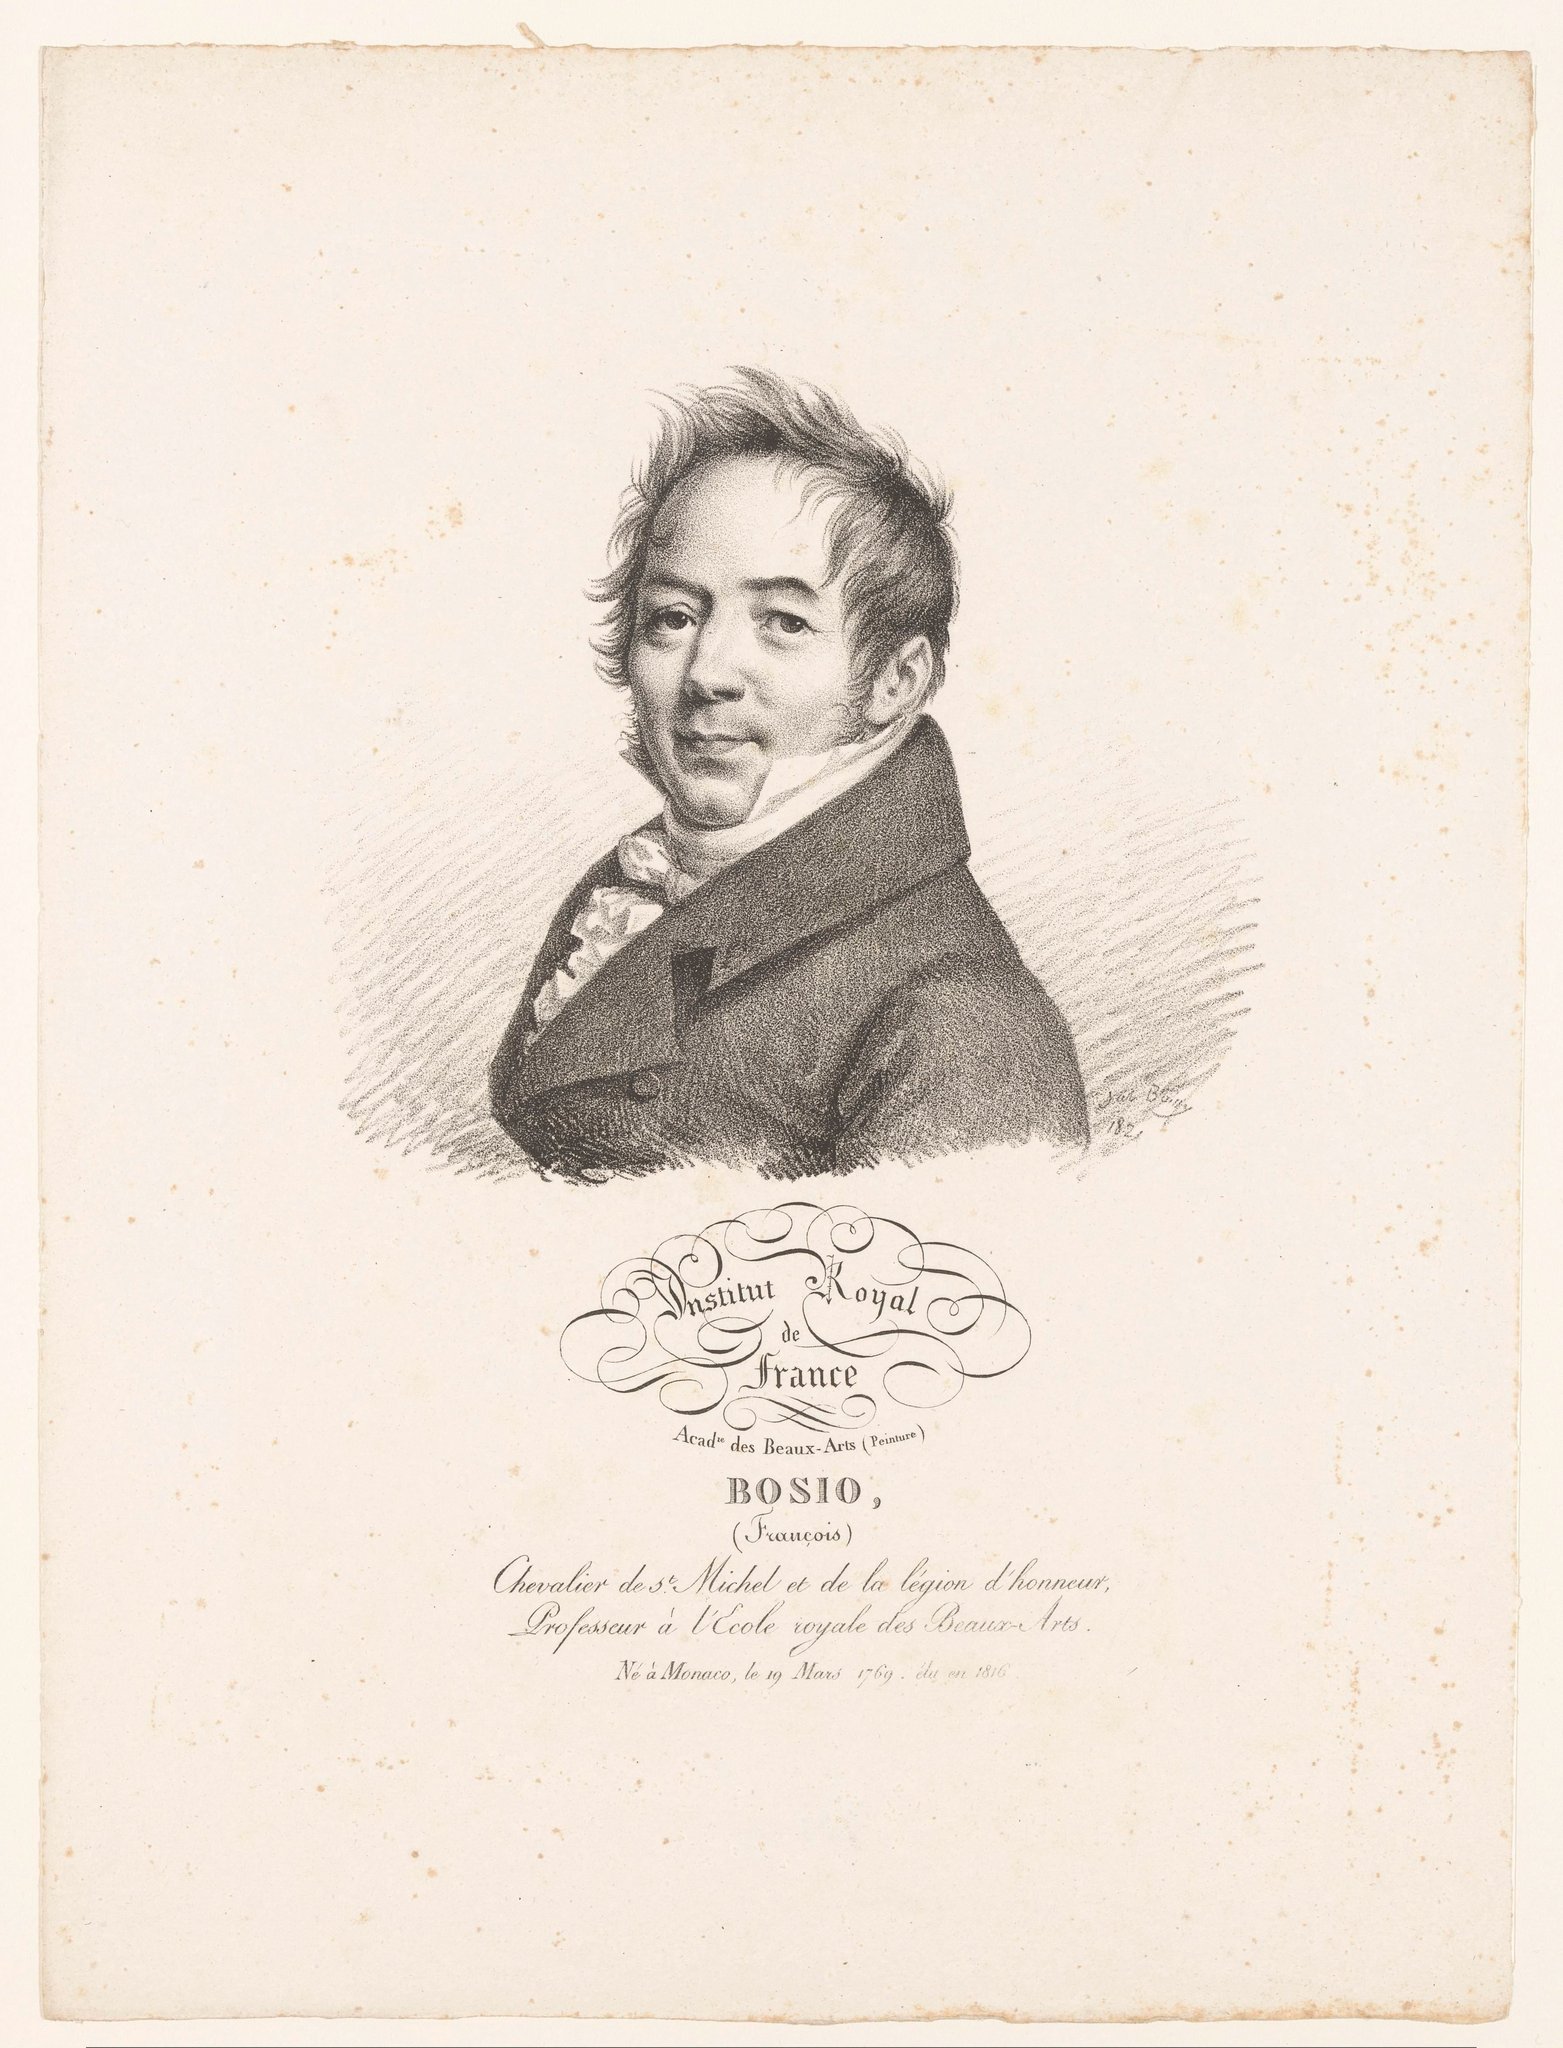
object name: print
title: Iconographie de l'Institut Royal de France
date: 1821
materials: paper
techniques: lithograph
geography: paris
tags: paris, painter, print maker, draughtsman, sculptor, françois-joseph bosio, historical persons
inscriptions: collector's mark: Lugt 2228a